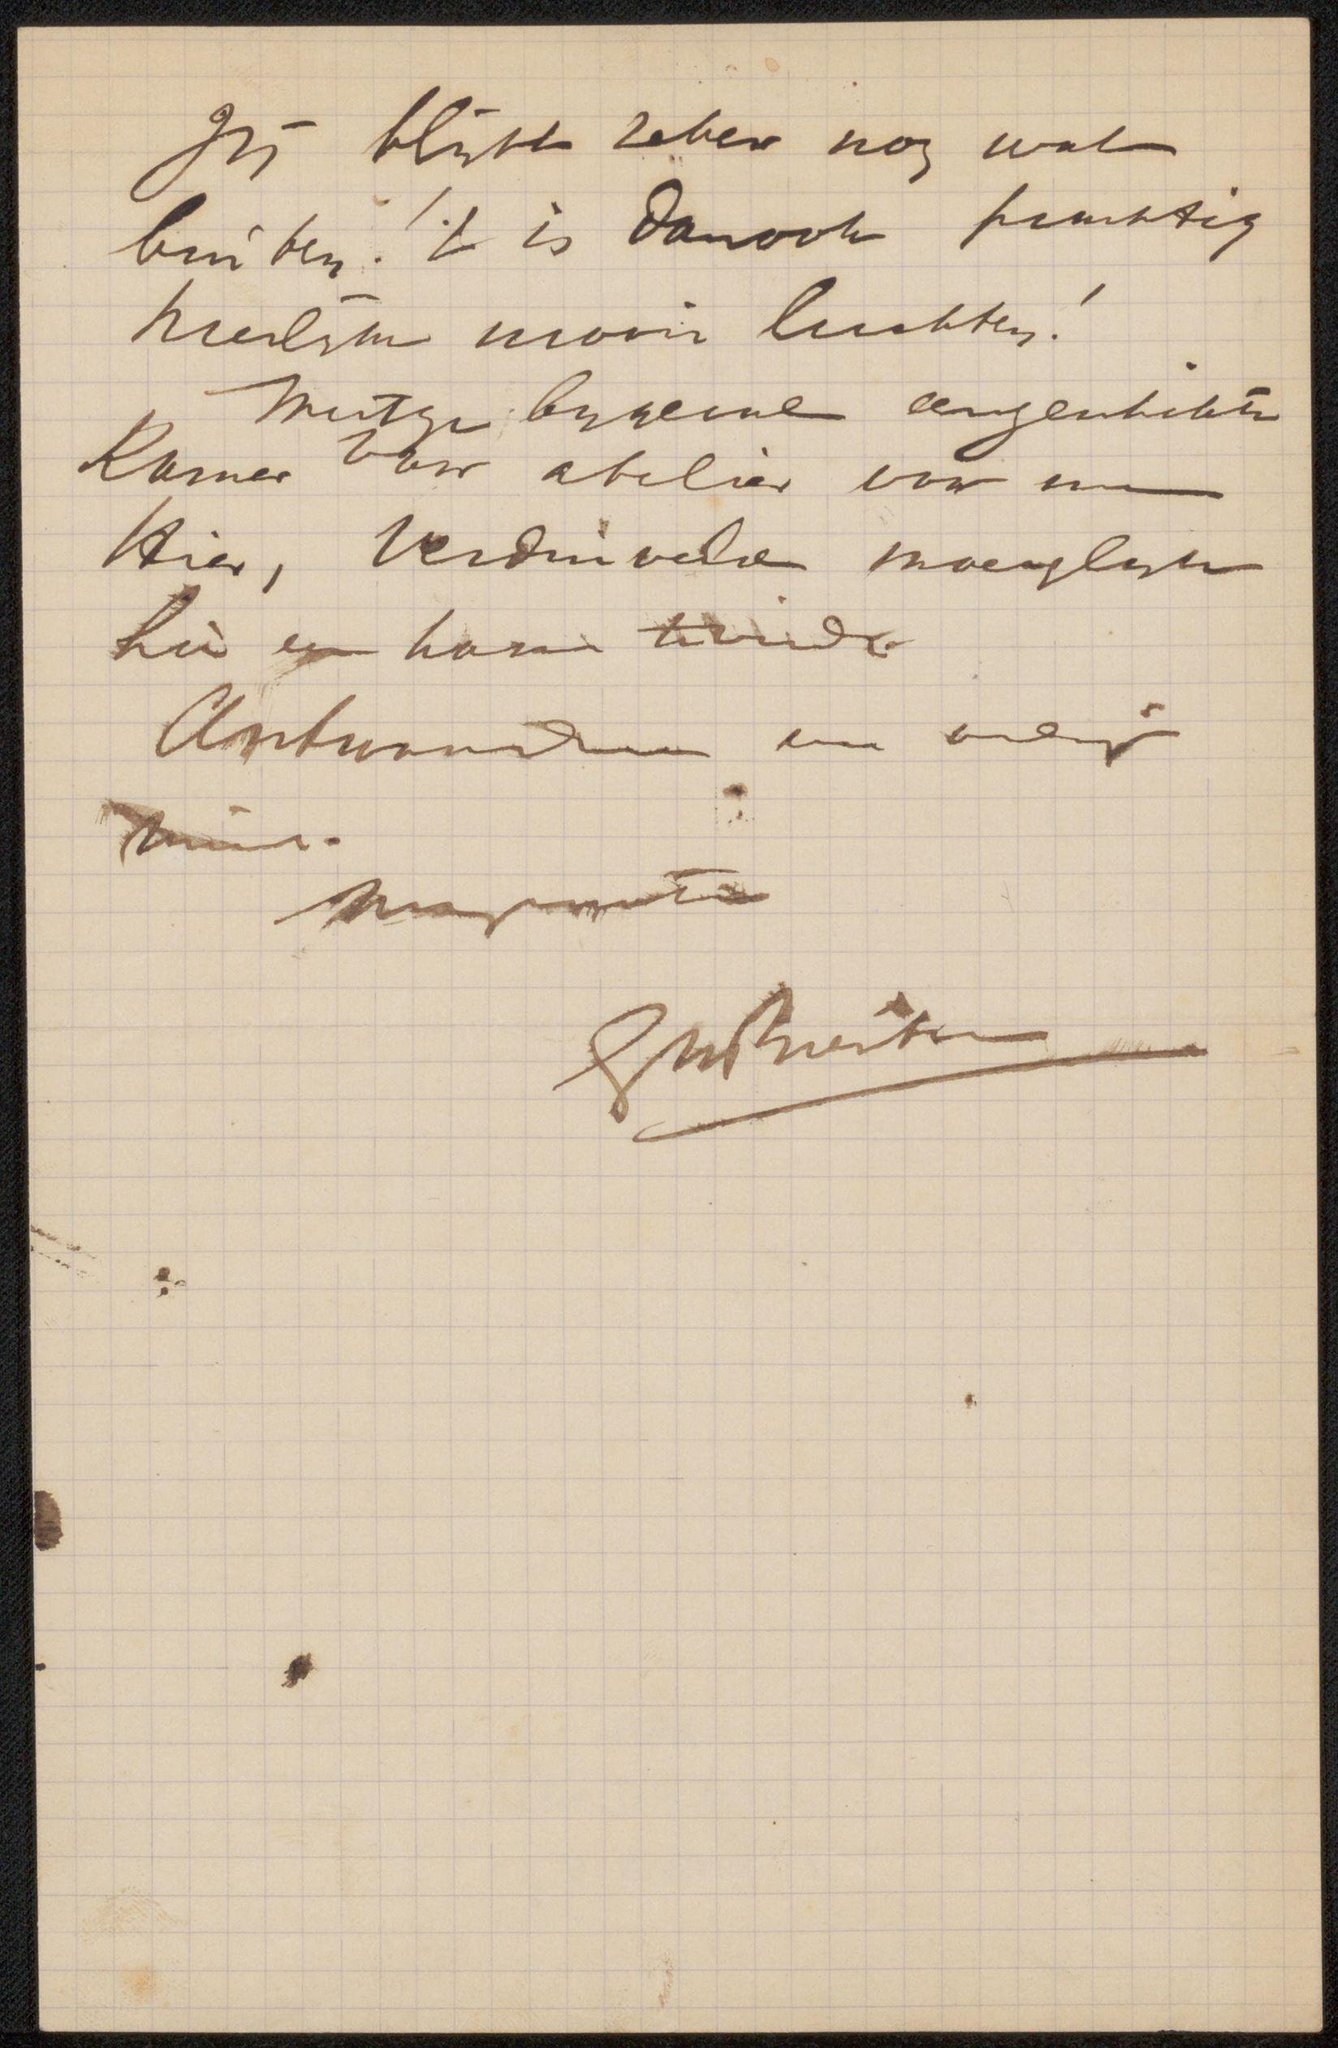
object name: letter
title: Brief aan Jan Veth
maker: george hendrik breitner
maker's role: draughtsman, painter, print maker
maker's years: 1857-1923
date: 1886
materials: ink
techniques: pen, writing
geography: amsterdam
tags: designer, jan veth, drawing, workshop, studio of the artist (in general), exhibition ~ art, the hague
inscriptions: collector's mark: ‘RPK’